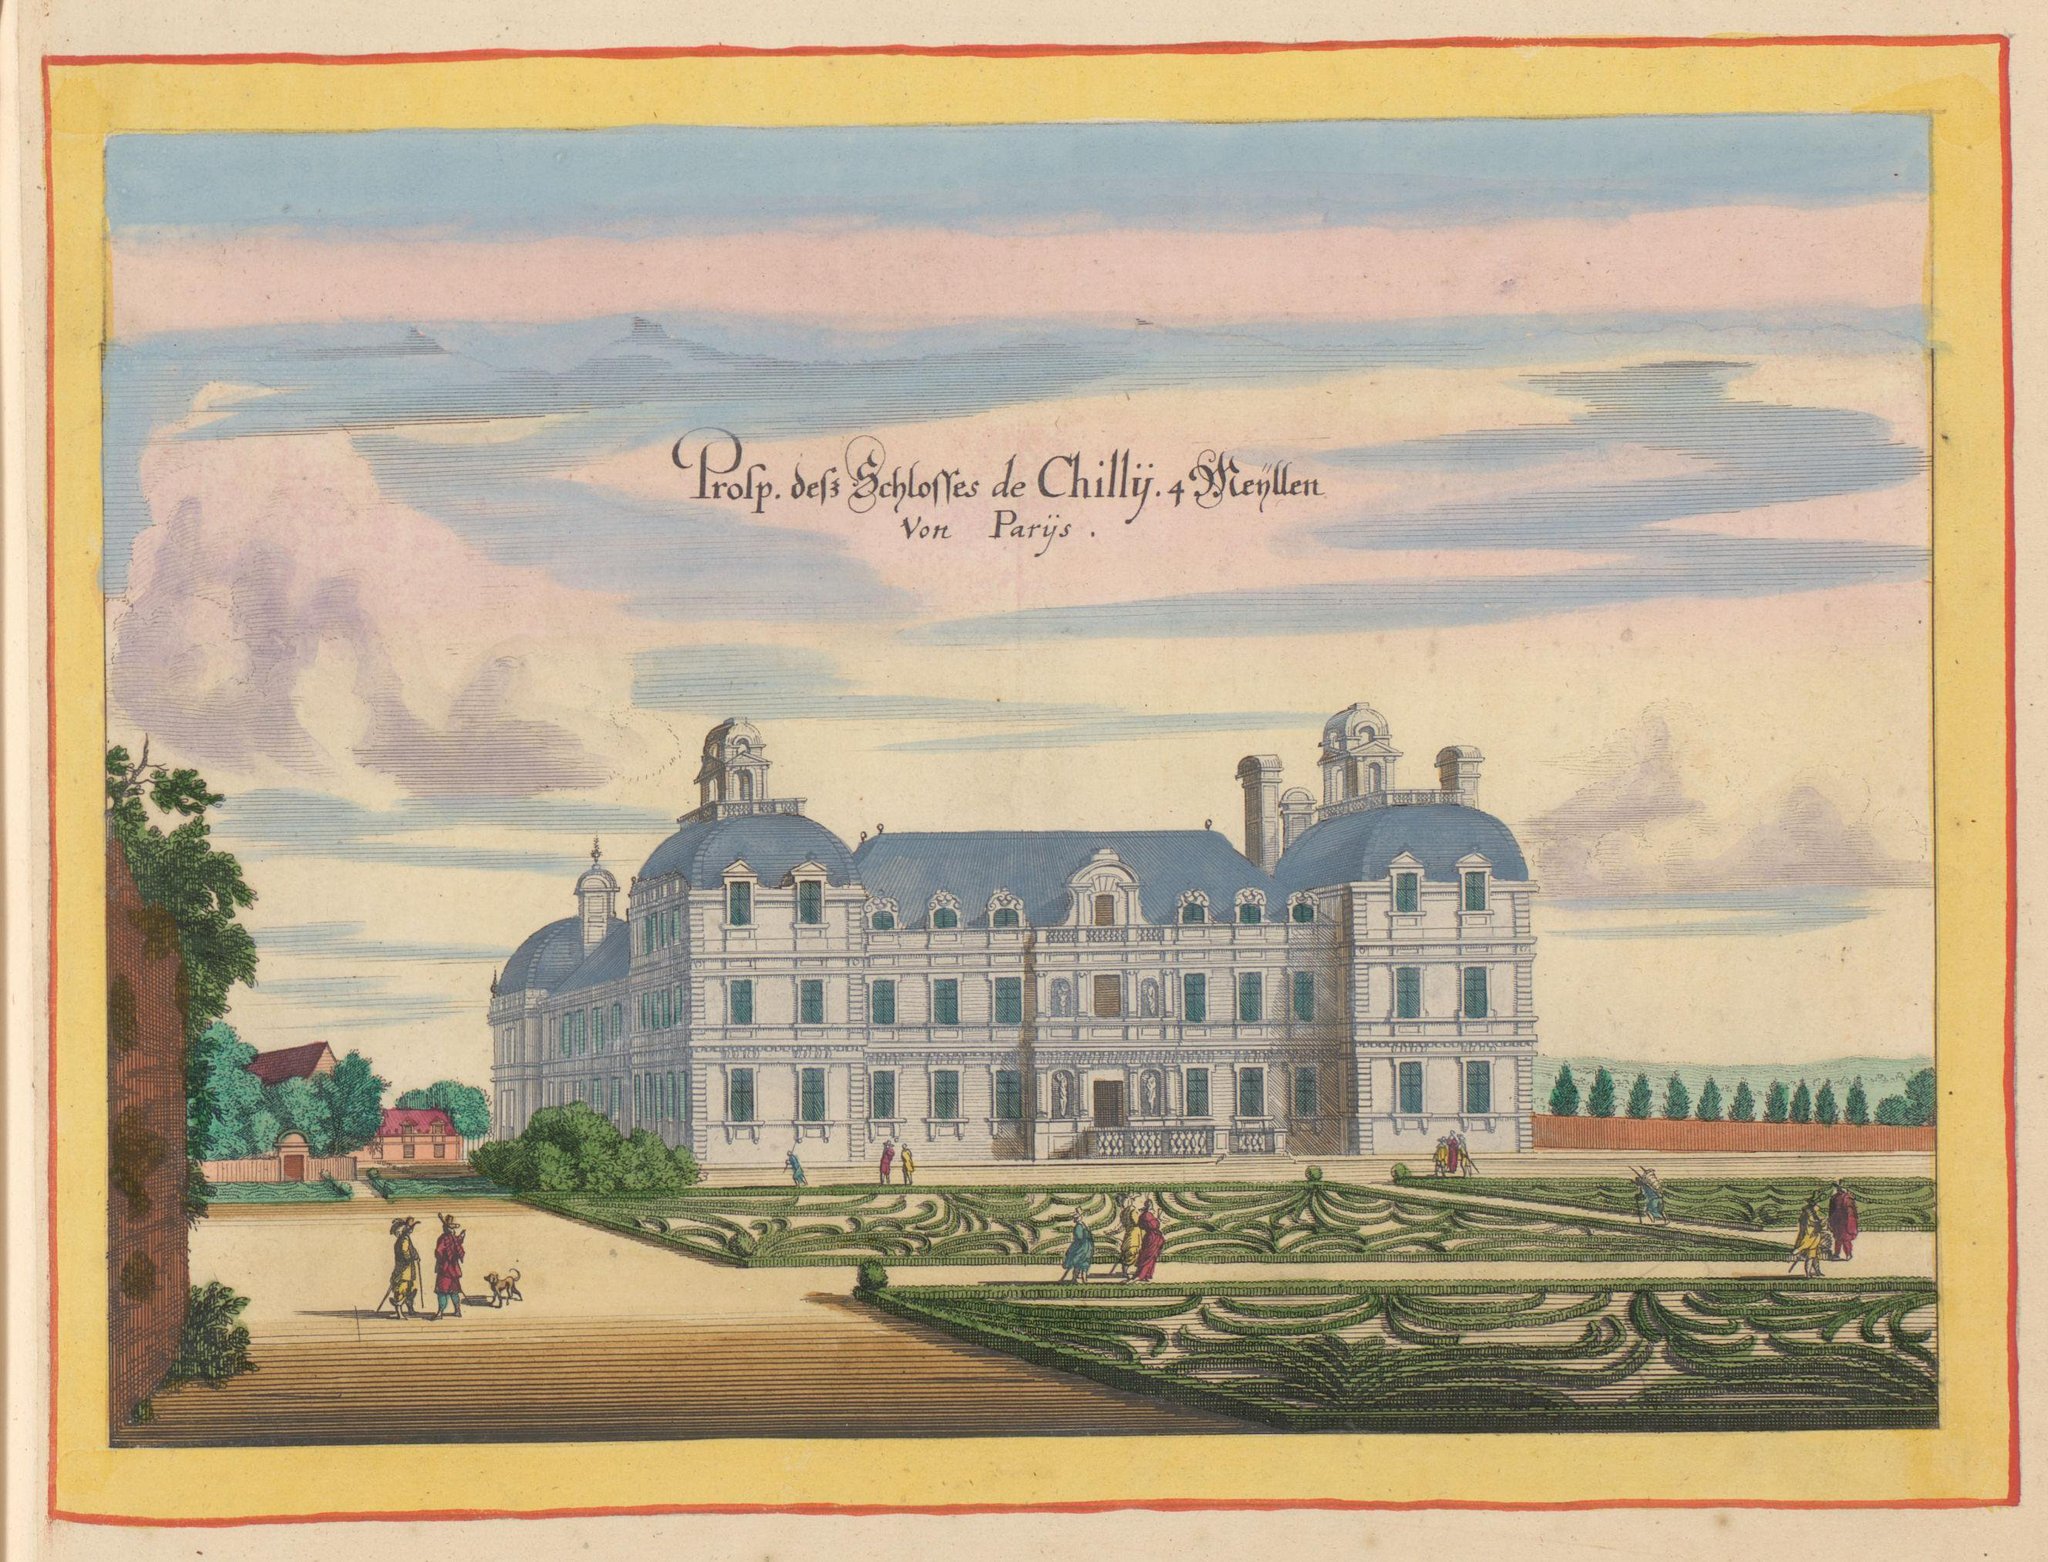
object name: album leaf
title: Prosp. dess Schlosses de Chillij 4 Meijllen von Parijs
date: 1655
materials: paper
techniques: engraving, etching, hand coloring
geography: paris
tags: castle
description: Prent origineel vervaardigd als boekillustratie voor: Zeiller, Martin. Topographia Galliae, oder Beschreibung und Contrafaitung der vornehmbsten und bekantisten Oerter in dem mächtigen und grossen Königreich Frankreich, 13 delen. Frankfurt am Main: Caspar Merian, 1655-1661. De prent werd voor het eerst gepubliceerd in deel 1: Topographia Galliae, 1655. De prent is langs de bovenrand van de voorstelling afgescheurd. De voorstelling is aan de bovenzijde aangevuld met een geschilderde lucht.